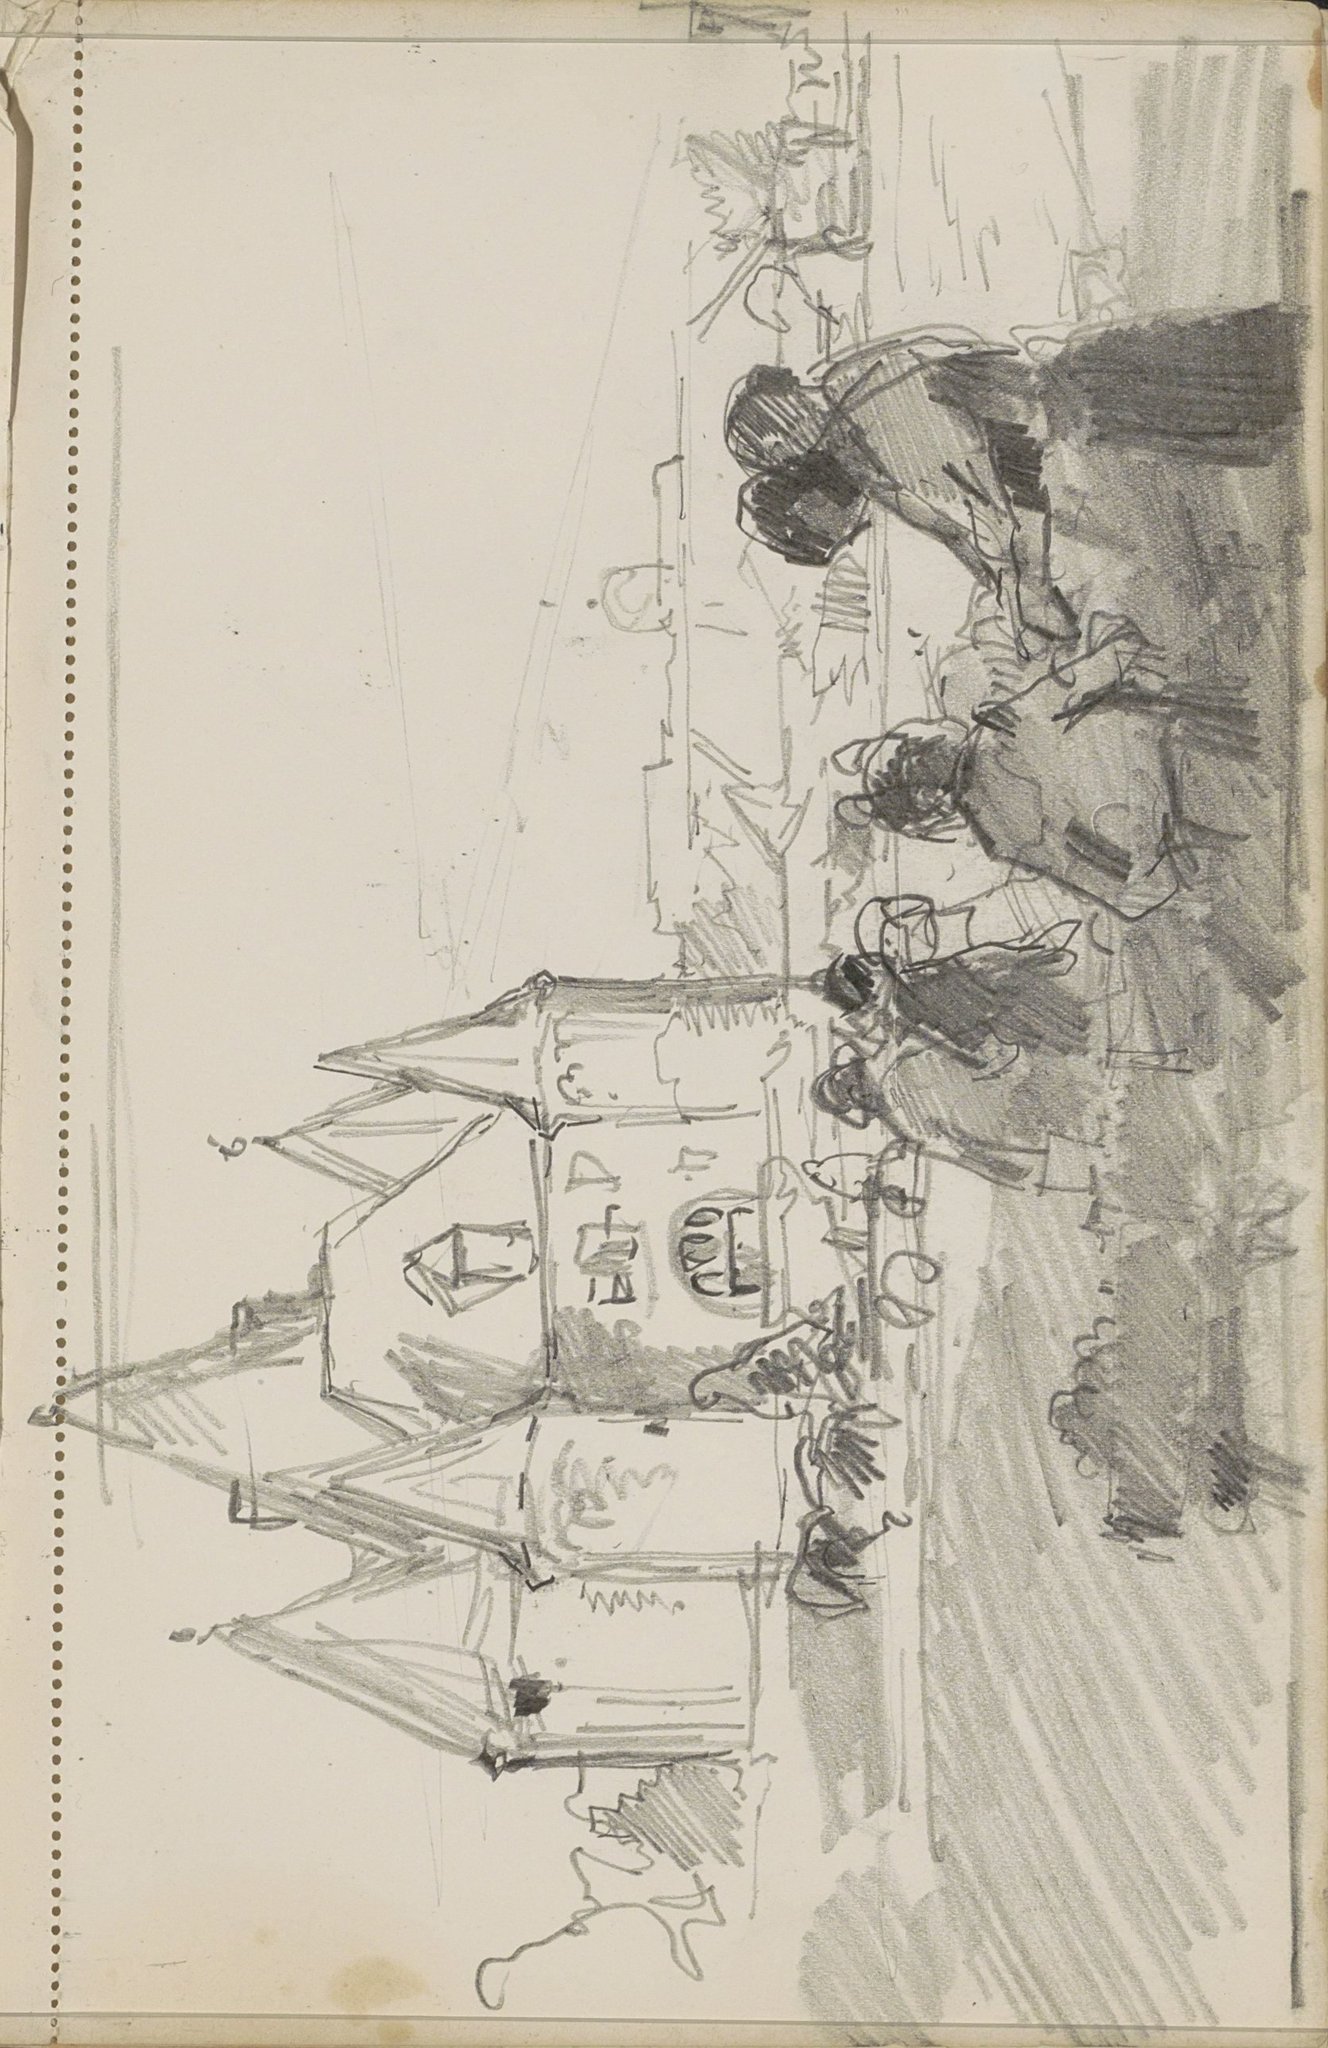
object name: sketchbook leaf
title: Waag op de Nieuwmarkt te Amsterdam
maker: cornelis vreedenburgh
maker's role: draughtsman, print maker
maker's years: 1880-1946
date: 1890-1946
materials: paper, pencil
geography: amsterdam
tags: civic architecture; edifices; dwellings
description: Blad 5 recto uit een schetsboek met 59 bladen.